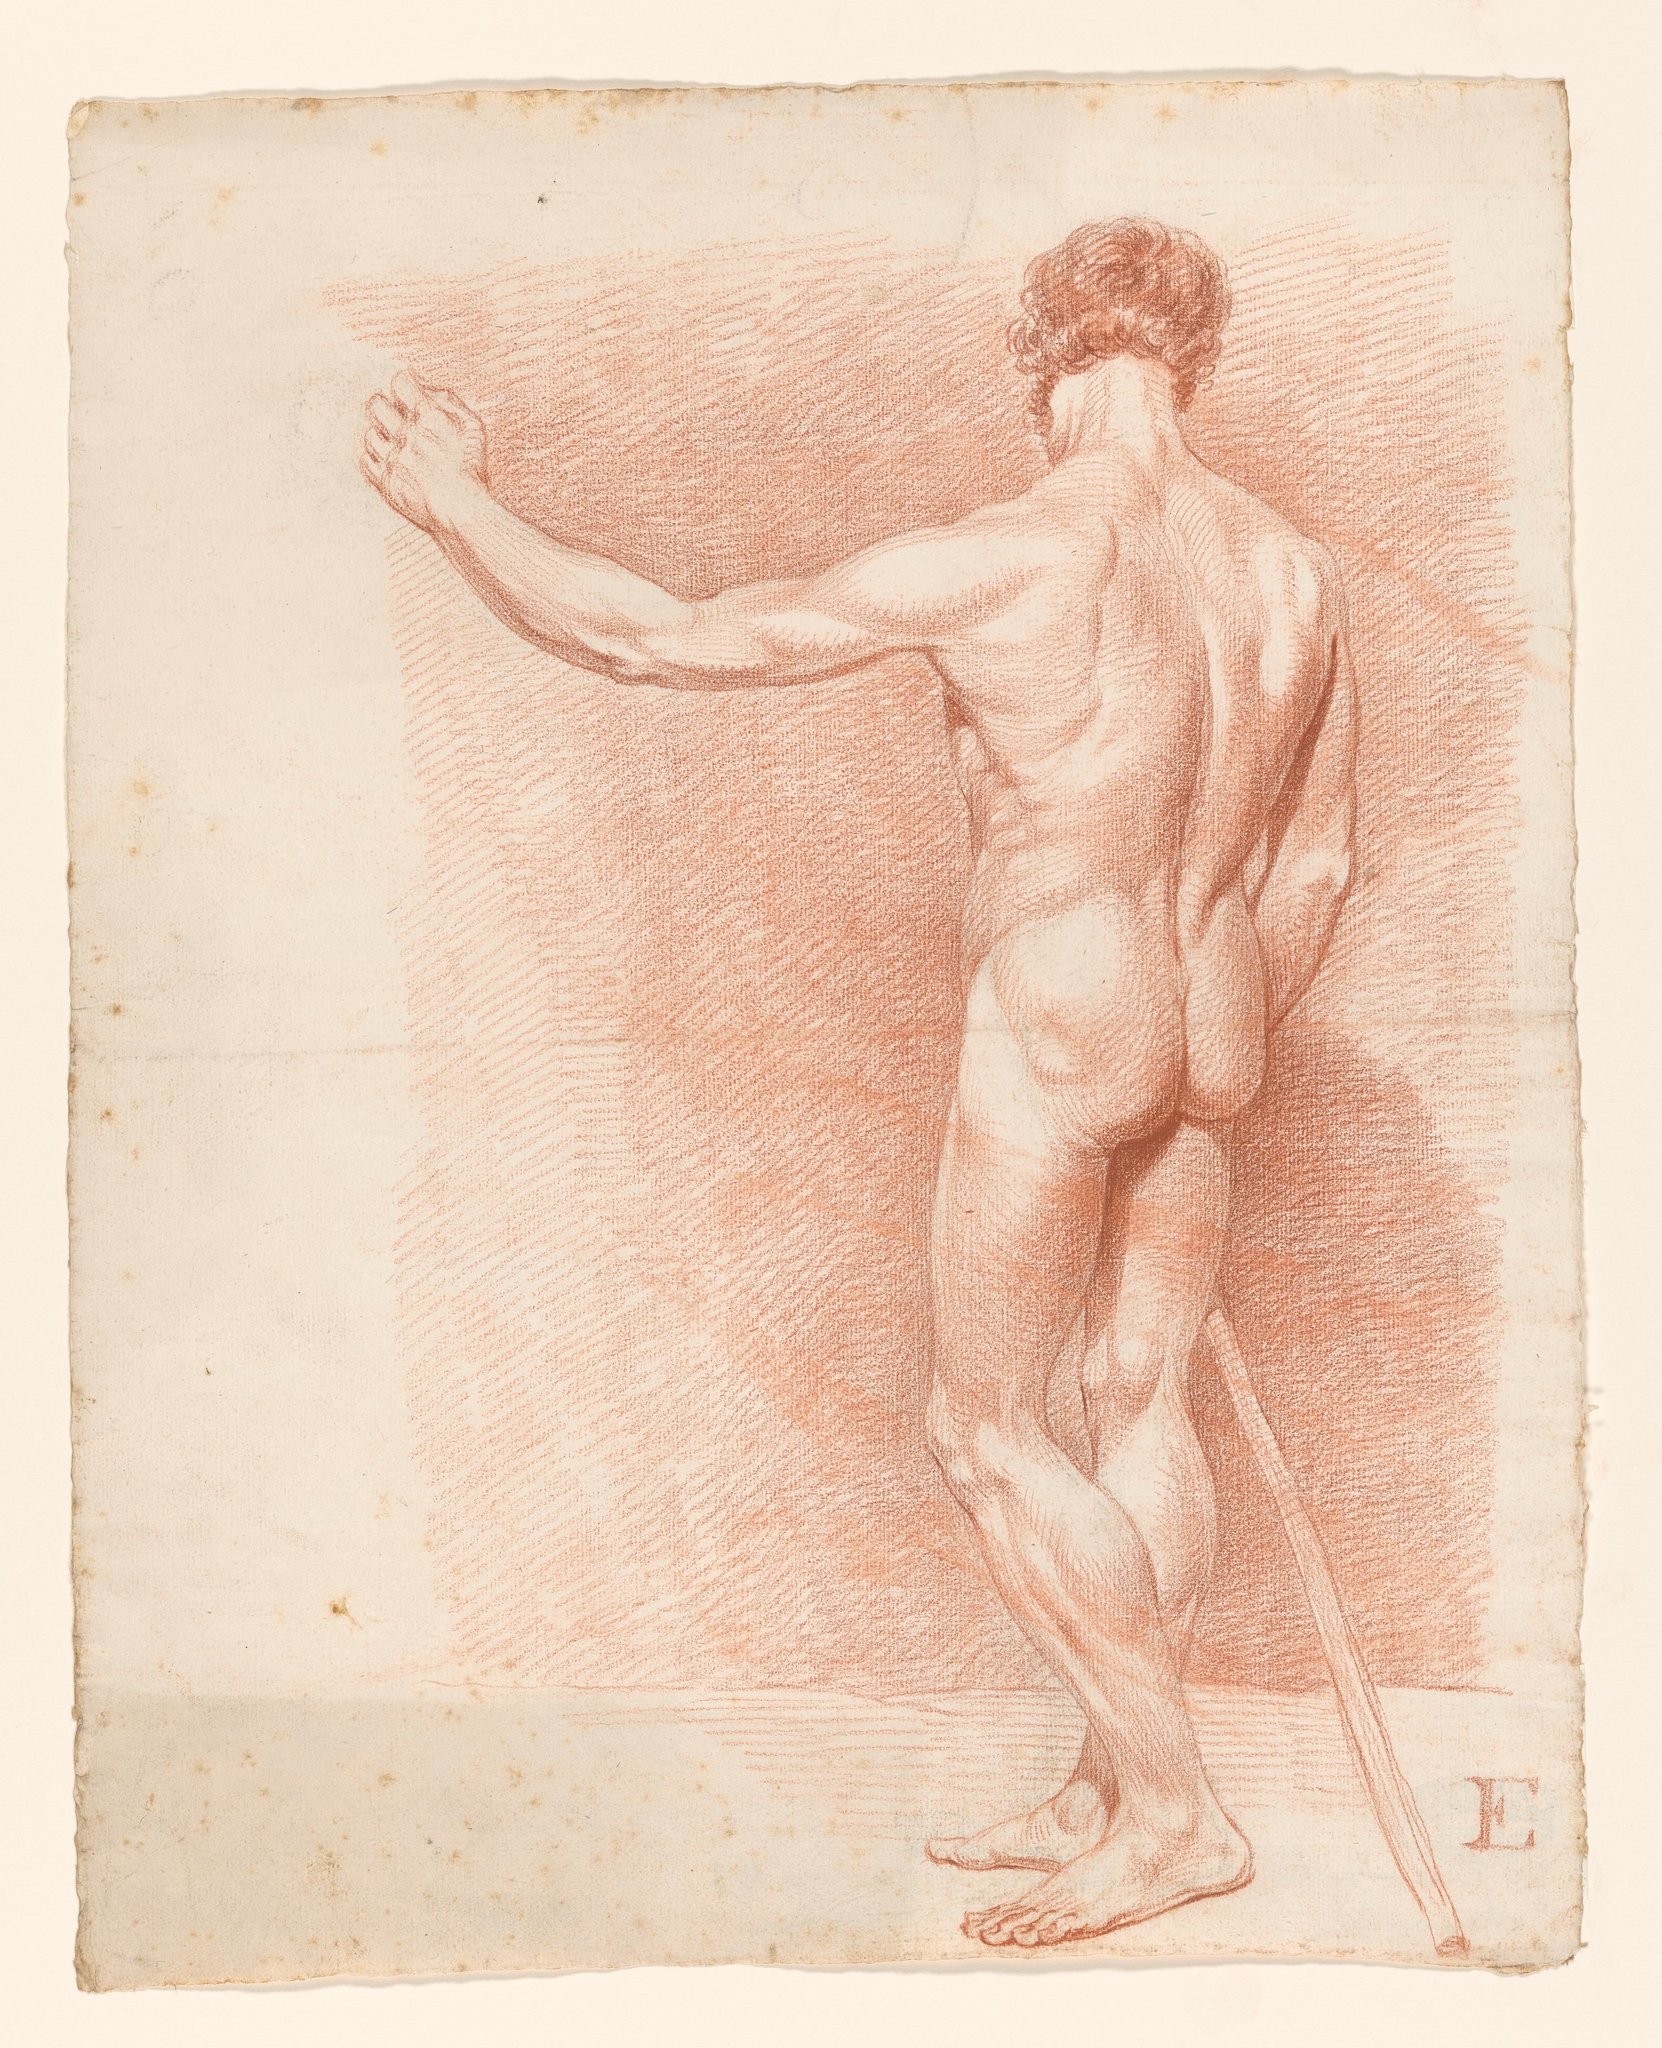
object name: drawing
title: Staand mannelijk naakt, op de rug gezien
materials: chalk, paper